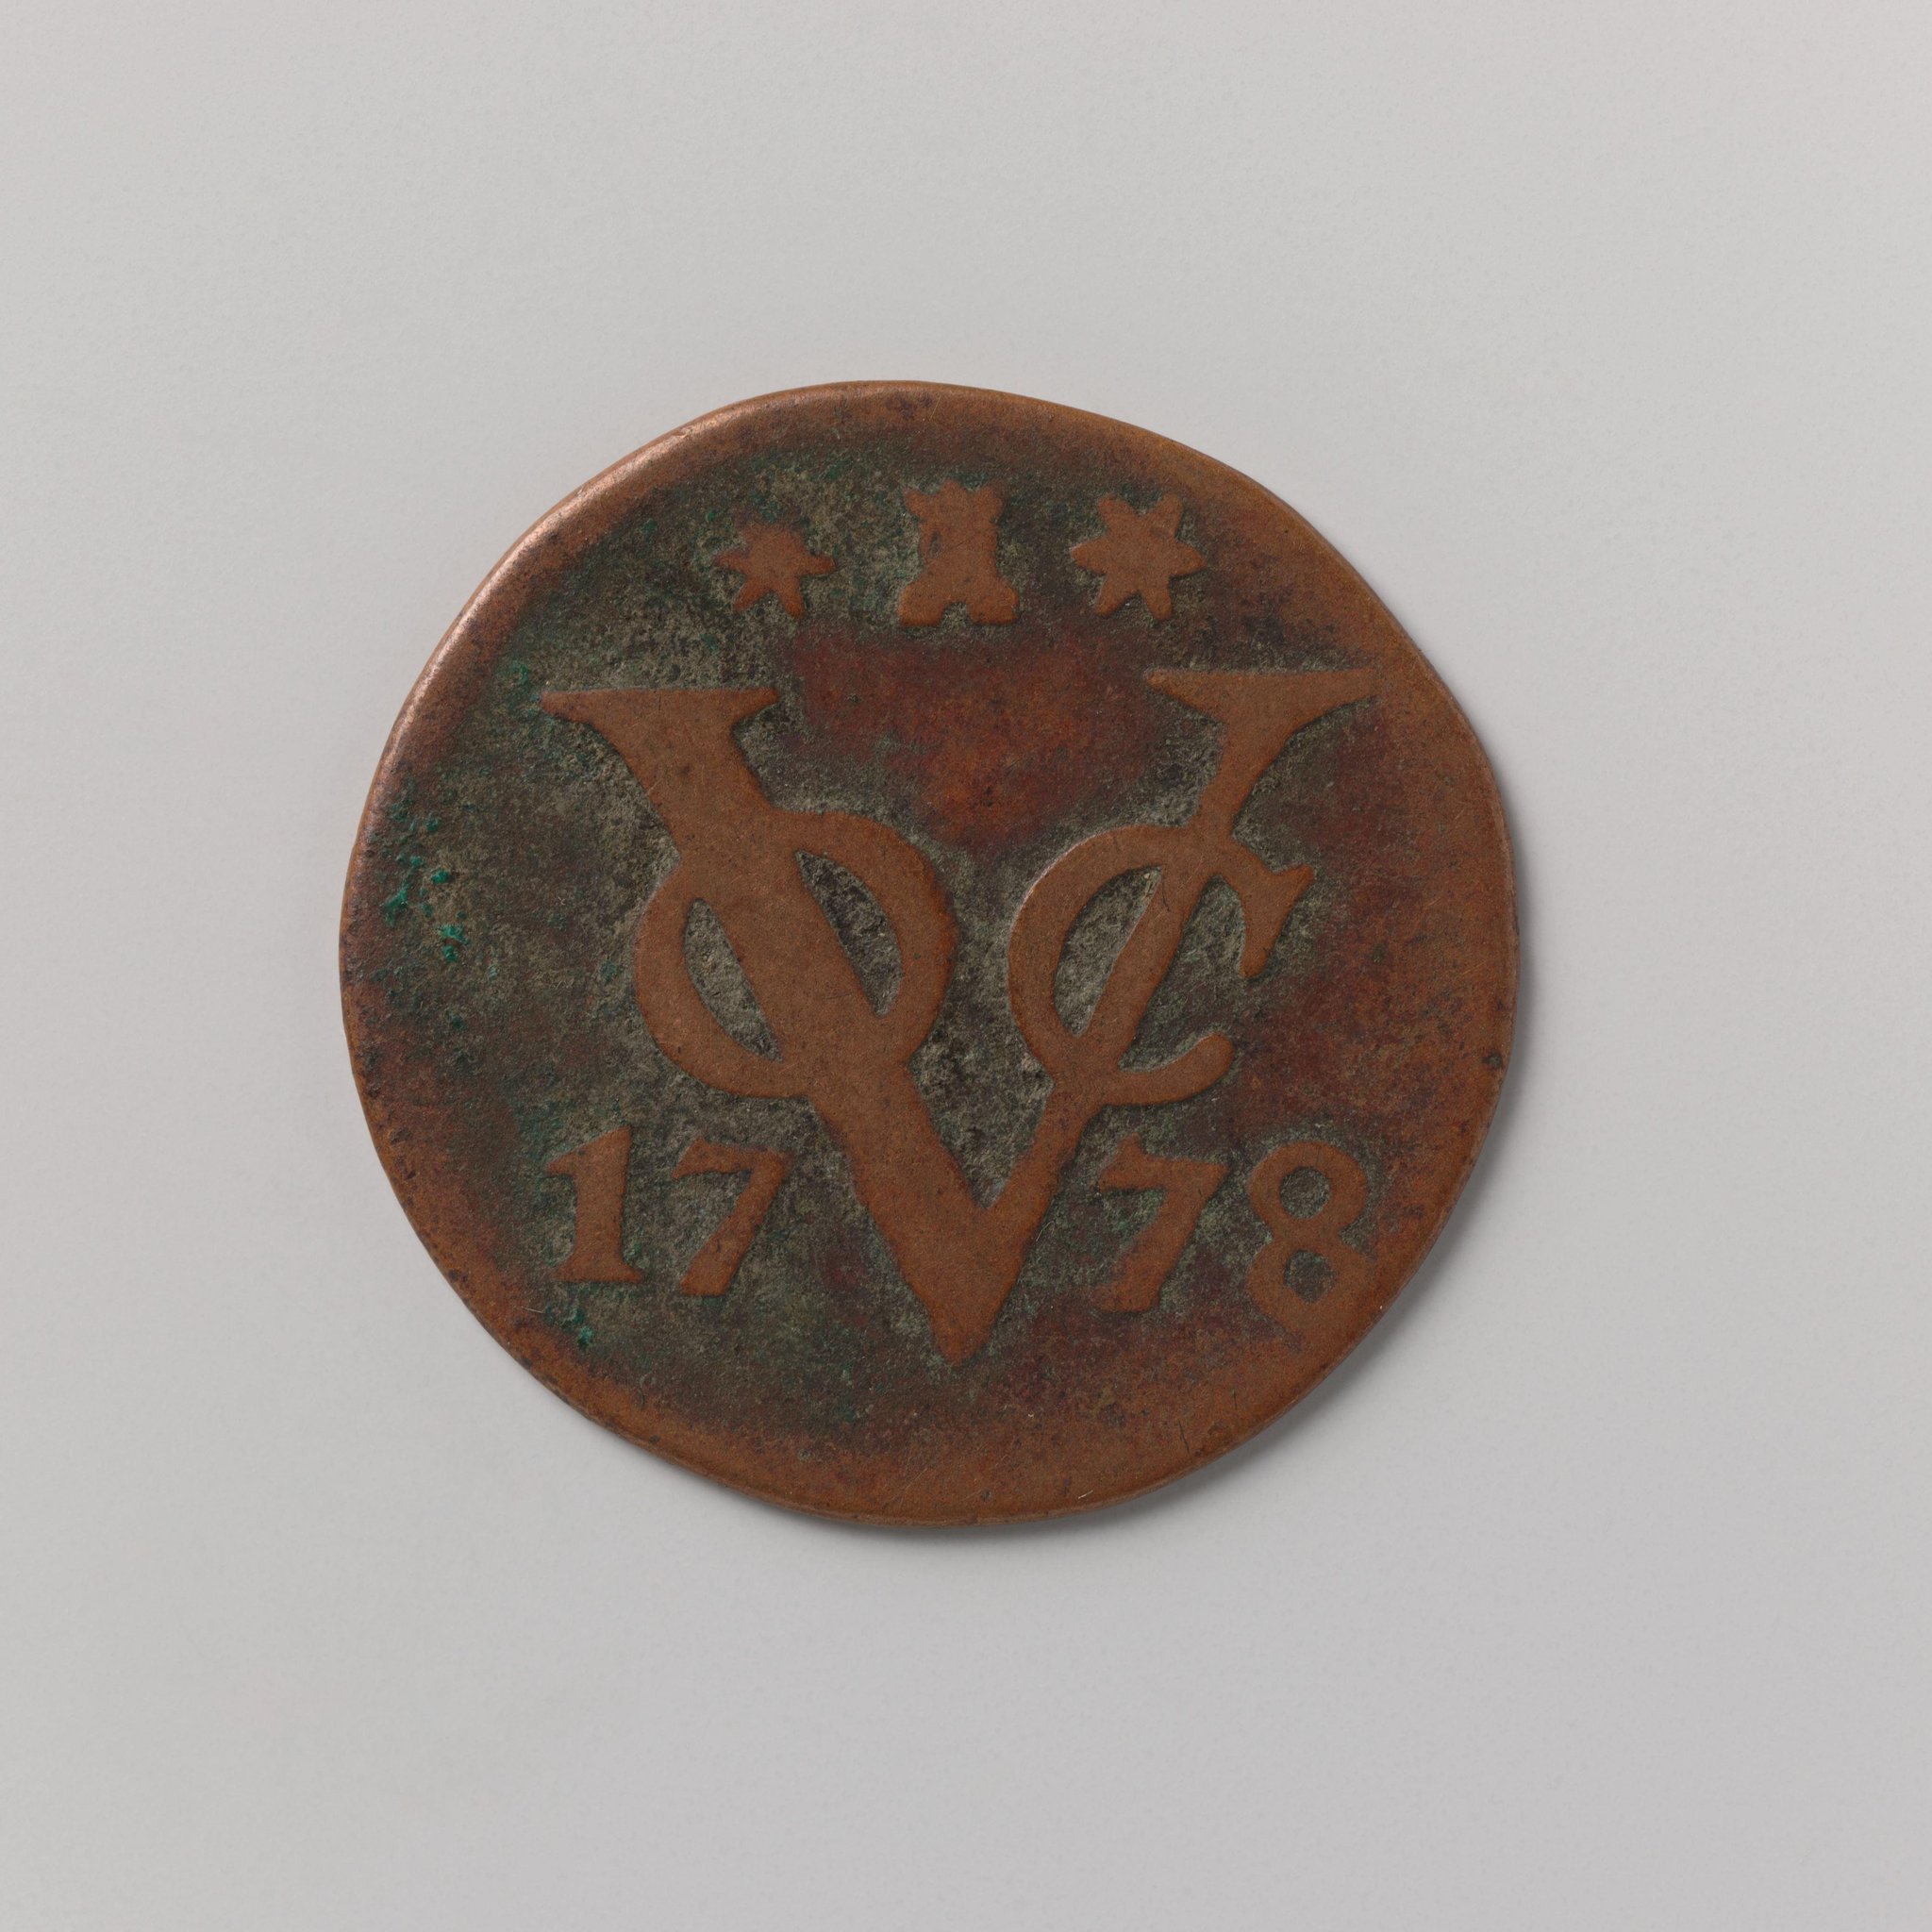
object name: coin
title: Duit van de VOC uit Zeeland, 1778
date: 1778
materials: copper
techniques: striking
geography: middelburg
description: Koperen munt. Voorzijde: gekroond wapenschild van Zeeland. Keerzijde: monogram van de VOC, waarboven muntteken en waaronder jaartal. Gladde rand.